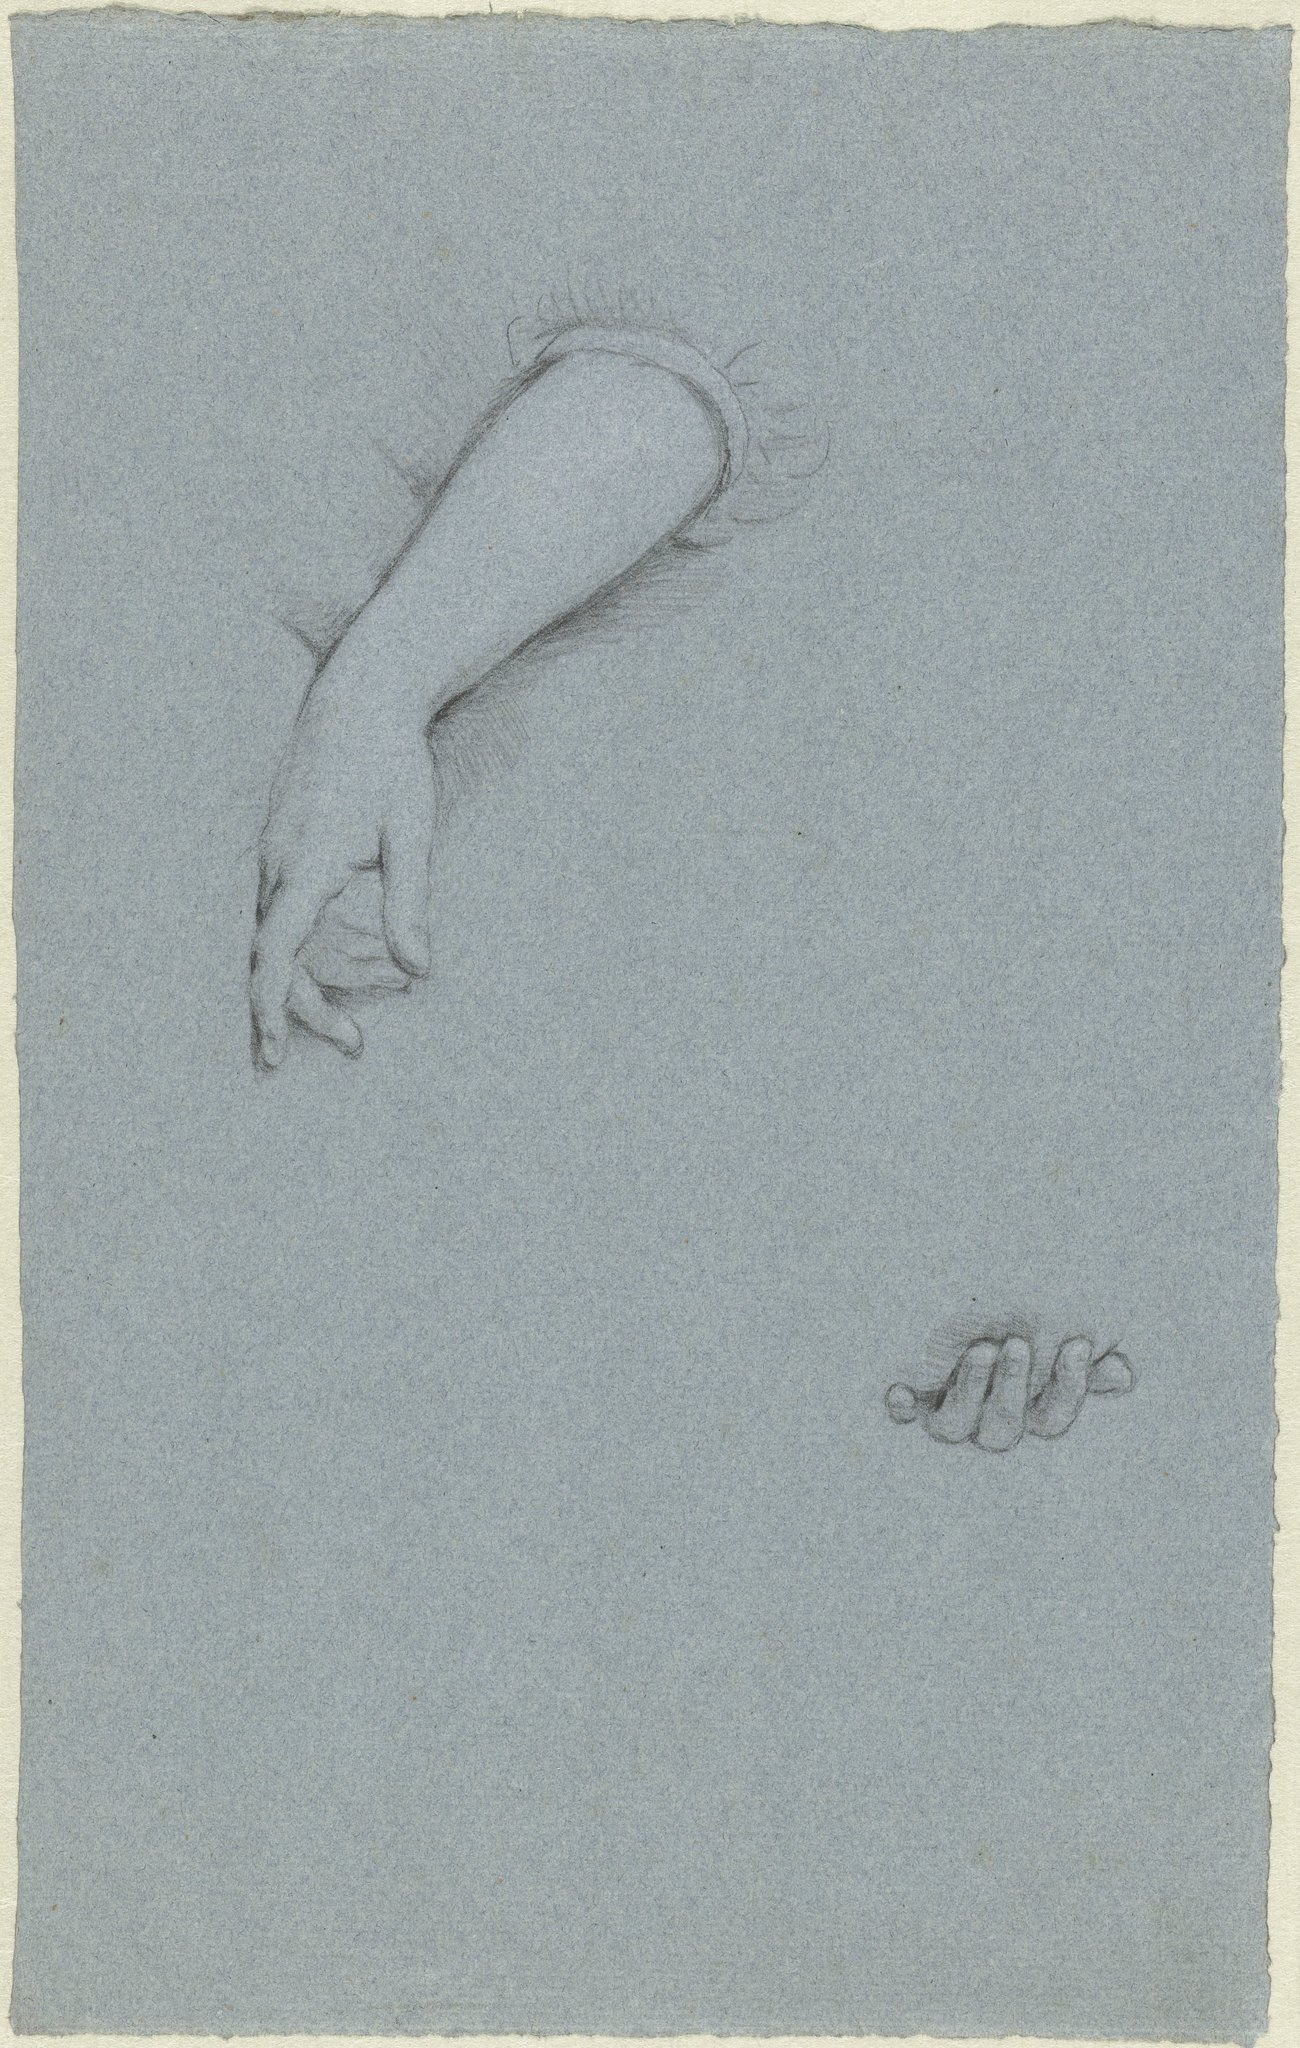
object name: drawing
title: Studies van een arm en van vingers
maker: caspar netscher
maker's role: draughtsman, painter, print maker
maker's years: 1639-1684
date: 1649-1684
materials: chalk, paper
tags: arms, fingers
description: Studie van een rechterarm met hand en van de vingers van een linkerhand.